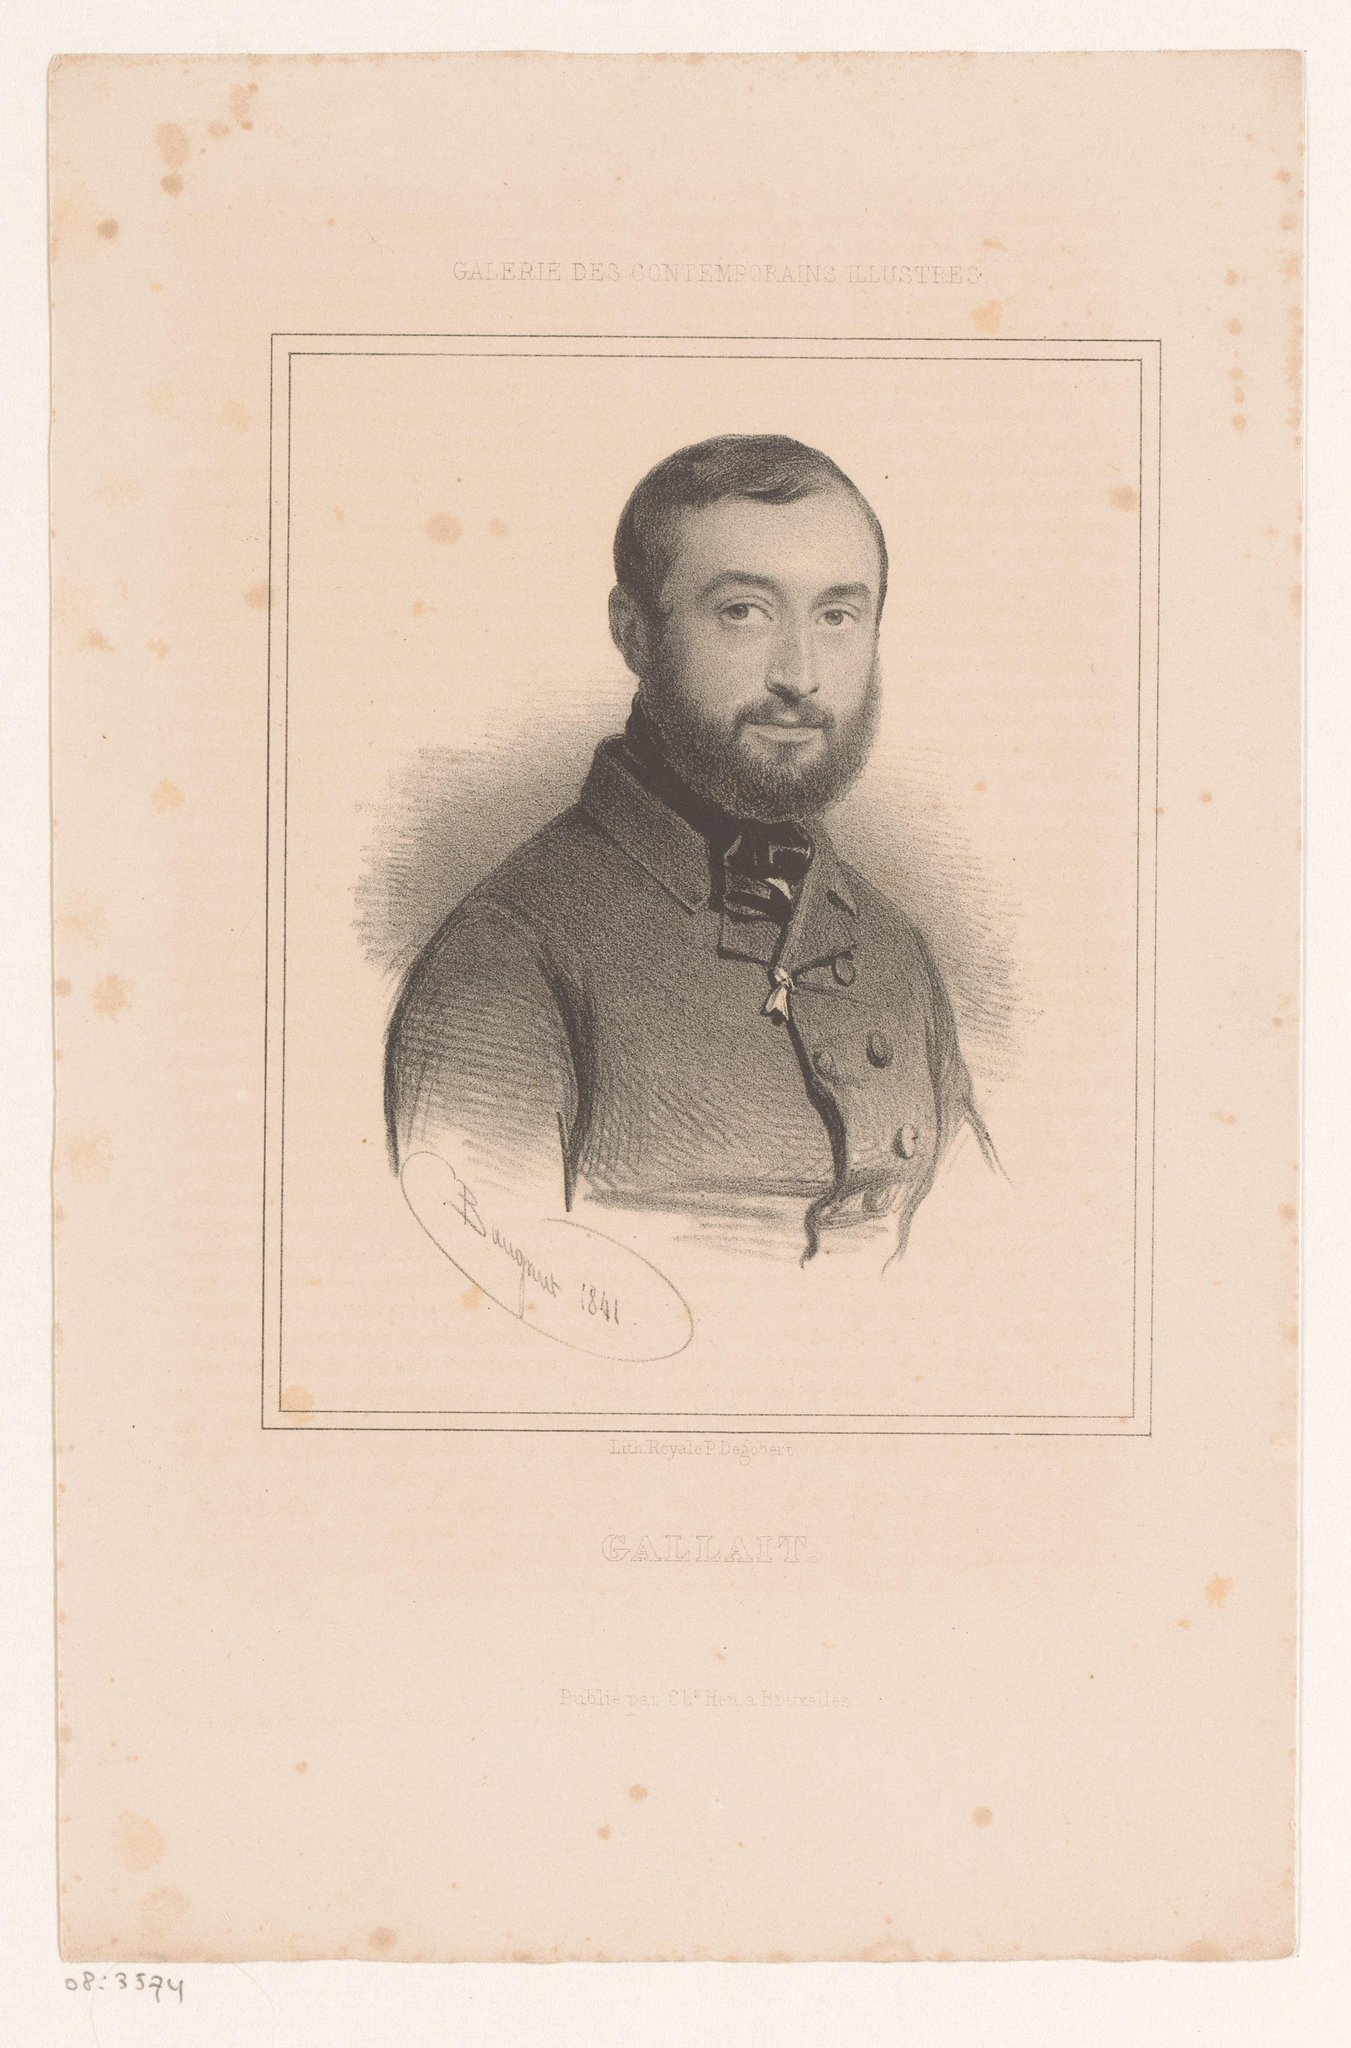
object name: print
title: Portretten van bekende personen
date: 1841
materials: paper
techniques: lithograph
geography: brussels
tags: painter, draughtsman, louis gallait, adult man, historical persons, beard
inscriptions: collector's mark: Lugt 2228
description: Prent uit: Galerie des contemporains illustres. Brussel: Ch. Hen, 1841.